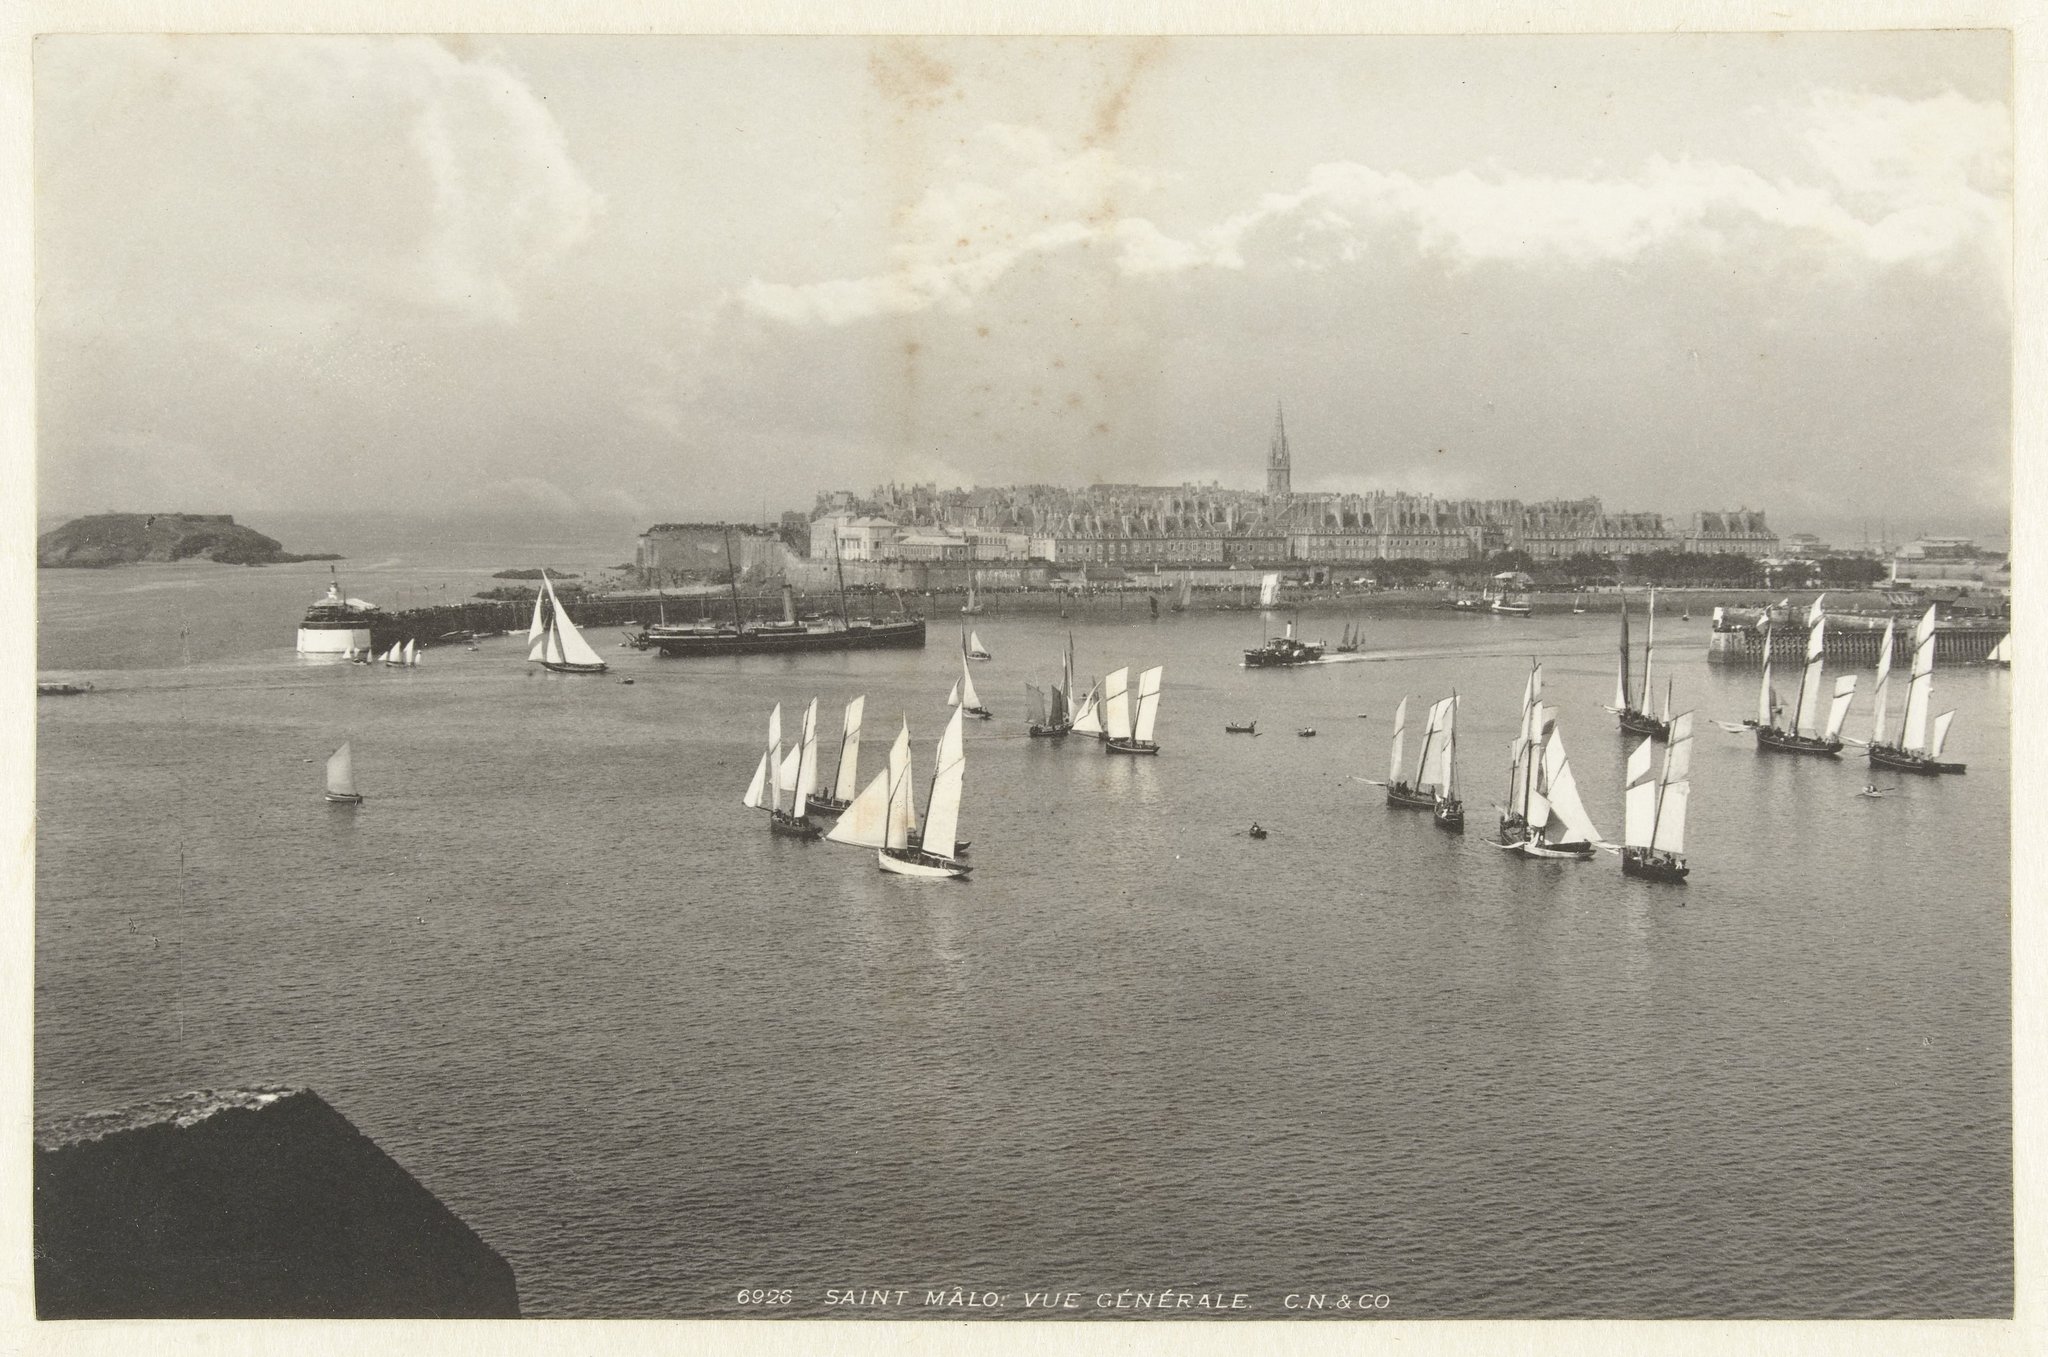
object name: photograph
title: Saint Malo. Vue Générale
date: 1880-1914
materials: paper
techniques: platinum process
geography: brittany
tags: harbour, gulf, bay, sailing-ship, sailing-boat, city-view in general; 'veduta'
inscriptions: inscription: ‘C/ 6926’, inscription: ‘6926 Saint Mâlo. Vue Générale. C.N. & Co.’